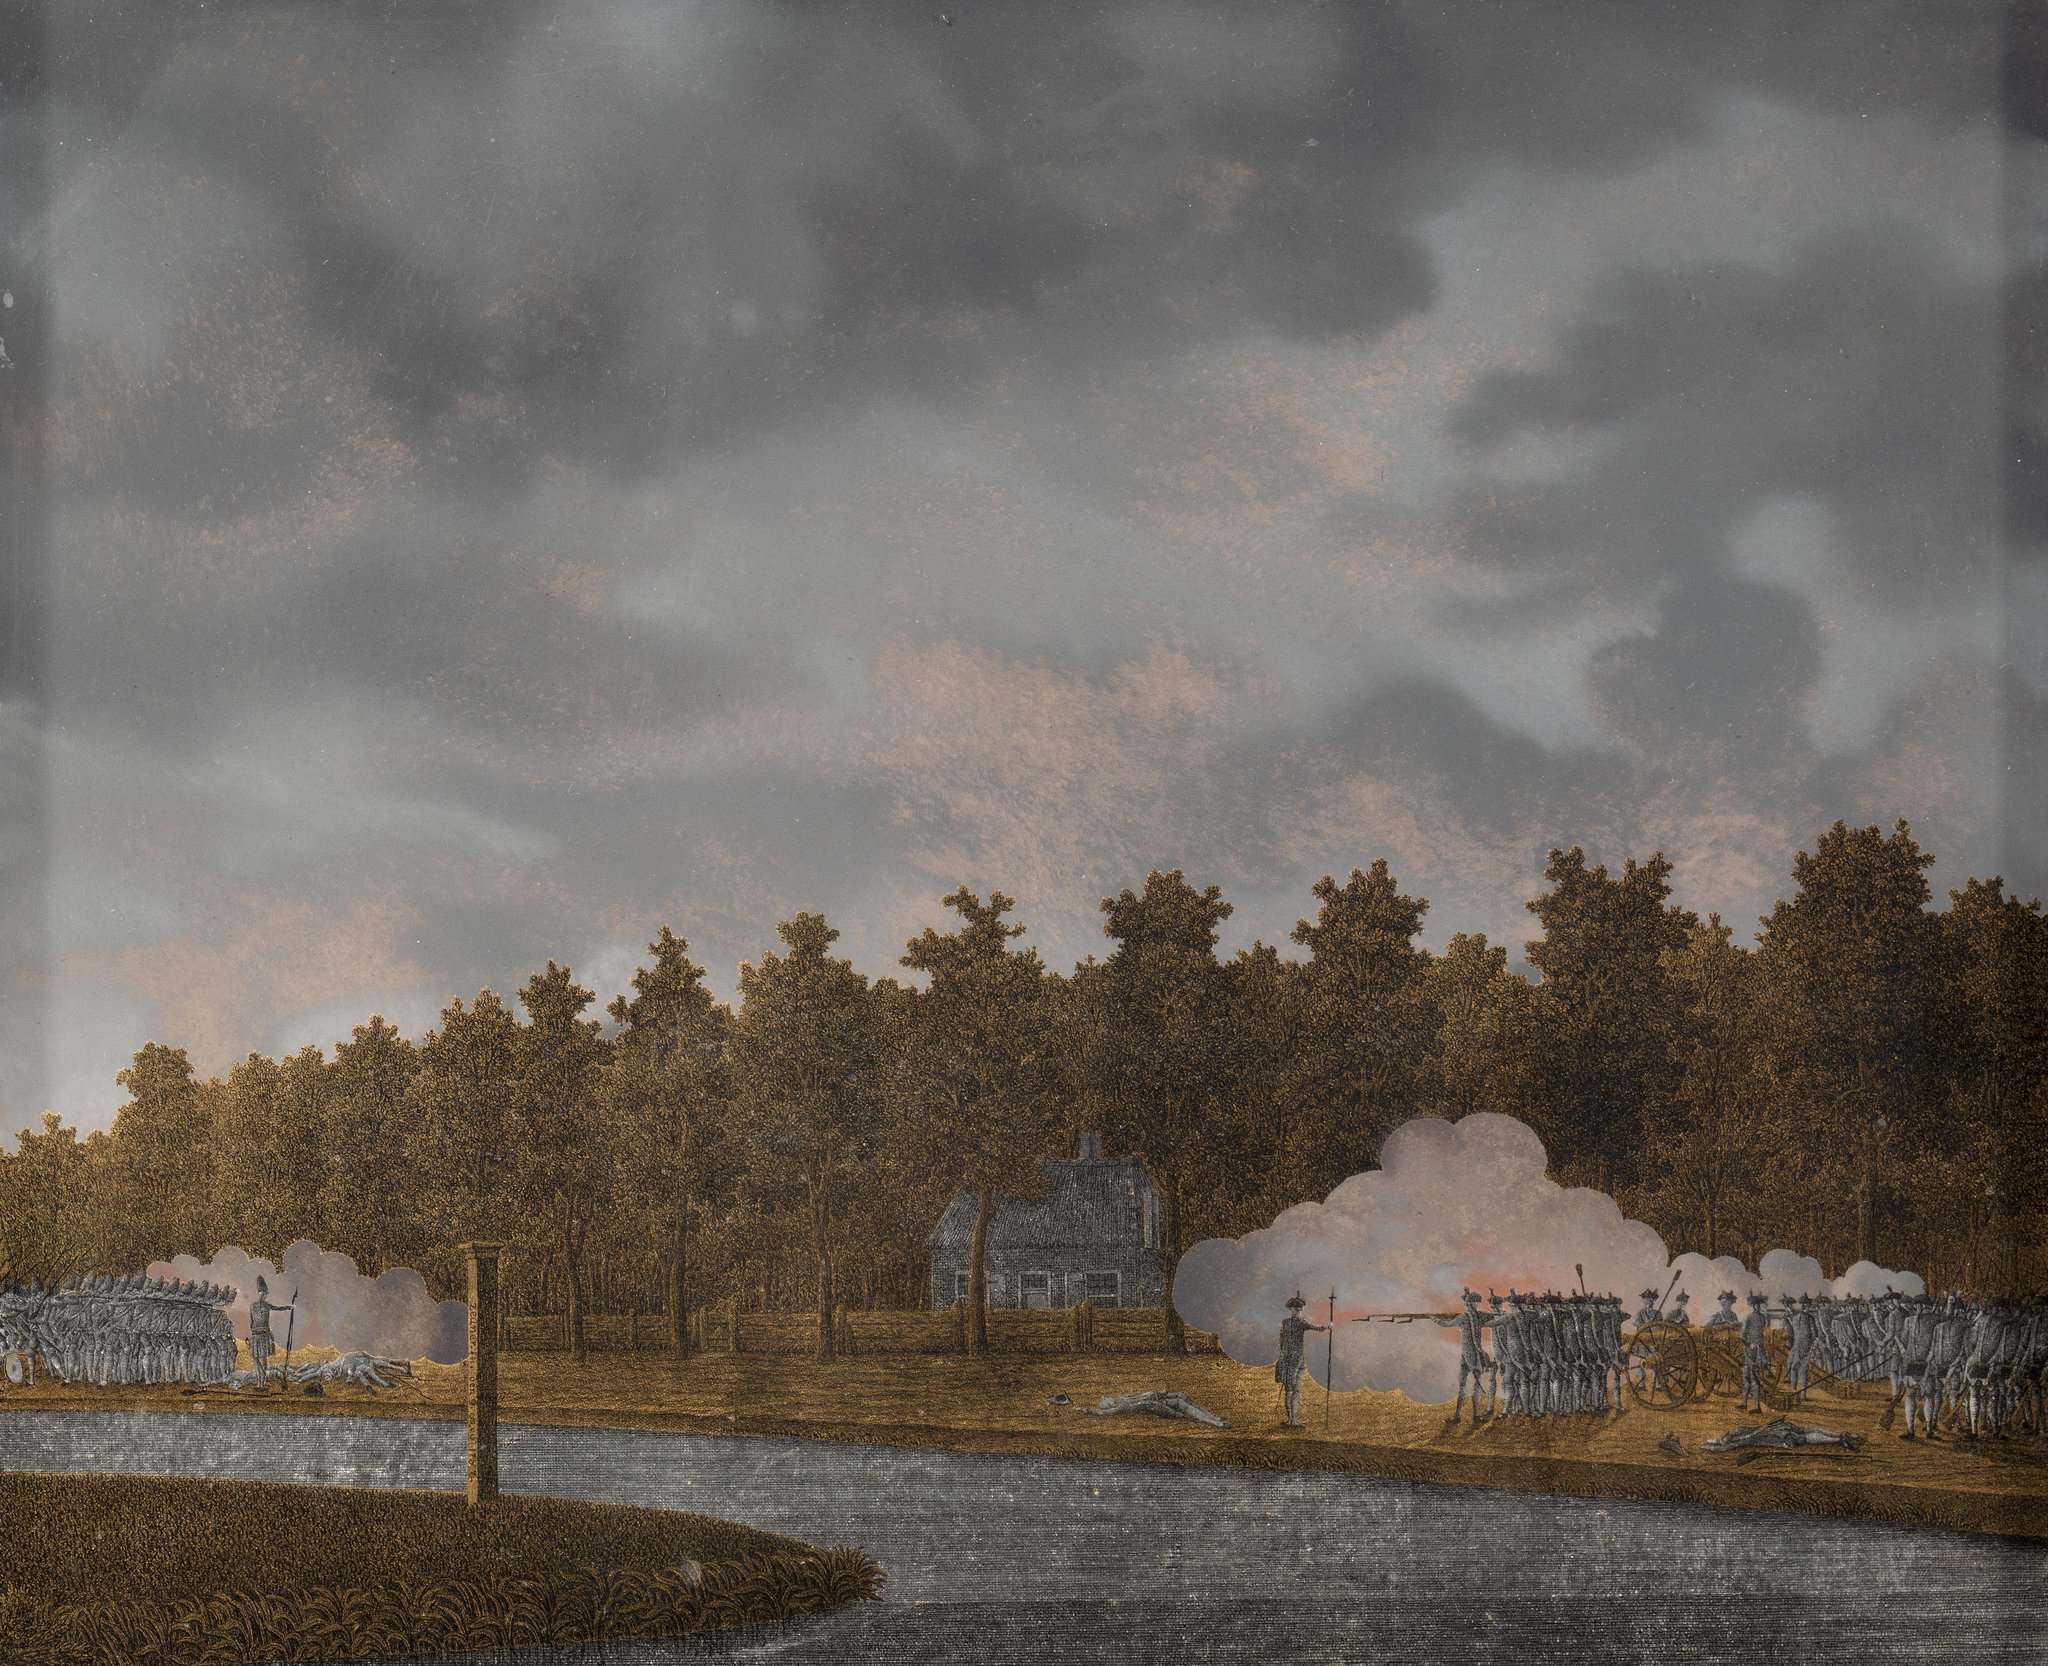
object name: reverse painting on glass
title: Exchange of Fire on the Vaartse Rijn near Jutphaas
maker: jonas zeuner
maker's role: painter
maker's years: 1727-1814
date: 1787-1788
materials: glass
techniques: glass painting, verre églomisé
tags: william v (prince of orange), battle, utrecht, patriots (1780-1795)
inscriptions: signature and date: ‘Zeuner fec. den 9. Mey 1787.’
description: A civil war between Orangists and Patriots raged in the Dutch Republic during 1786 and 1787. In May 1787, the Stadtholder’s army tried to cut off the city of Utrecht, which was in the hands of the Patriots, from the neighbouring Patriot-held province of Holland. The Patriots succeeded in repelling the attack on 9 May. Seen at left are the Stadtholder’s troops and at the right the Utrecht Patriots.